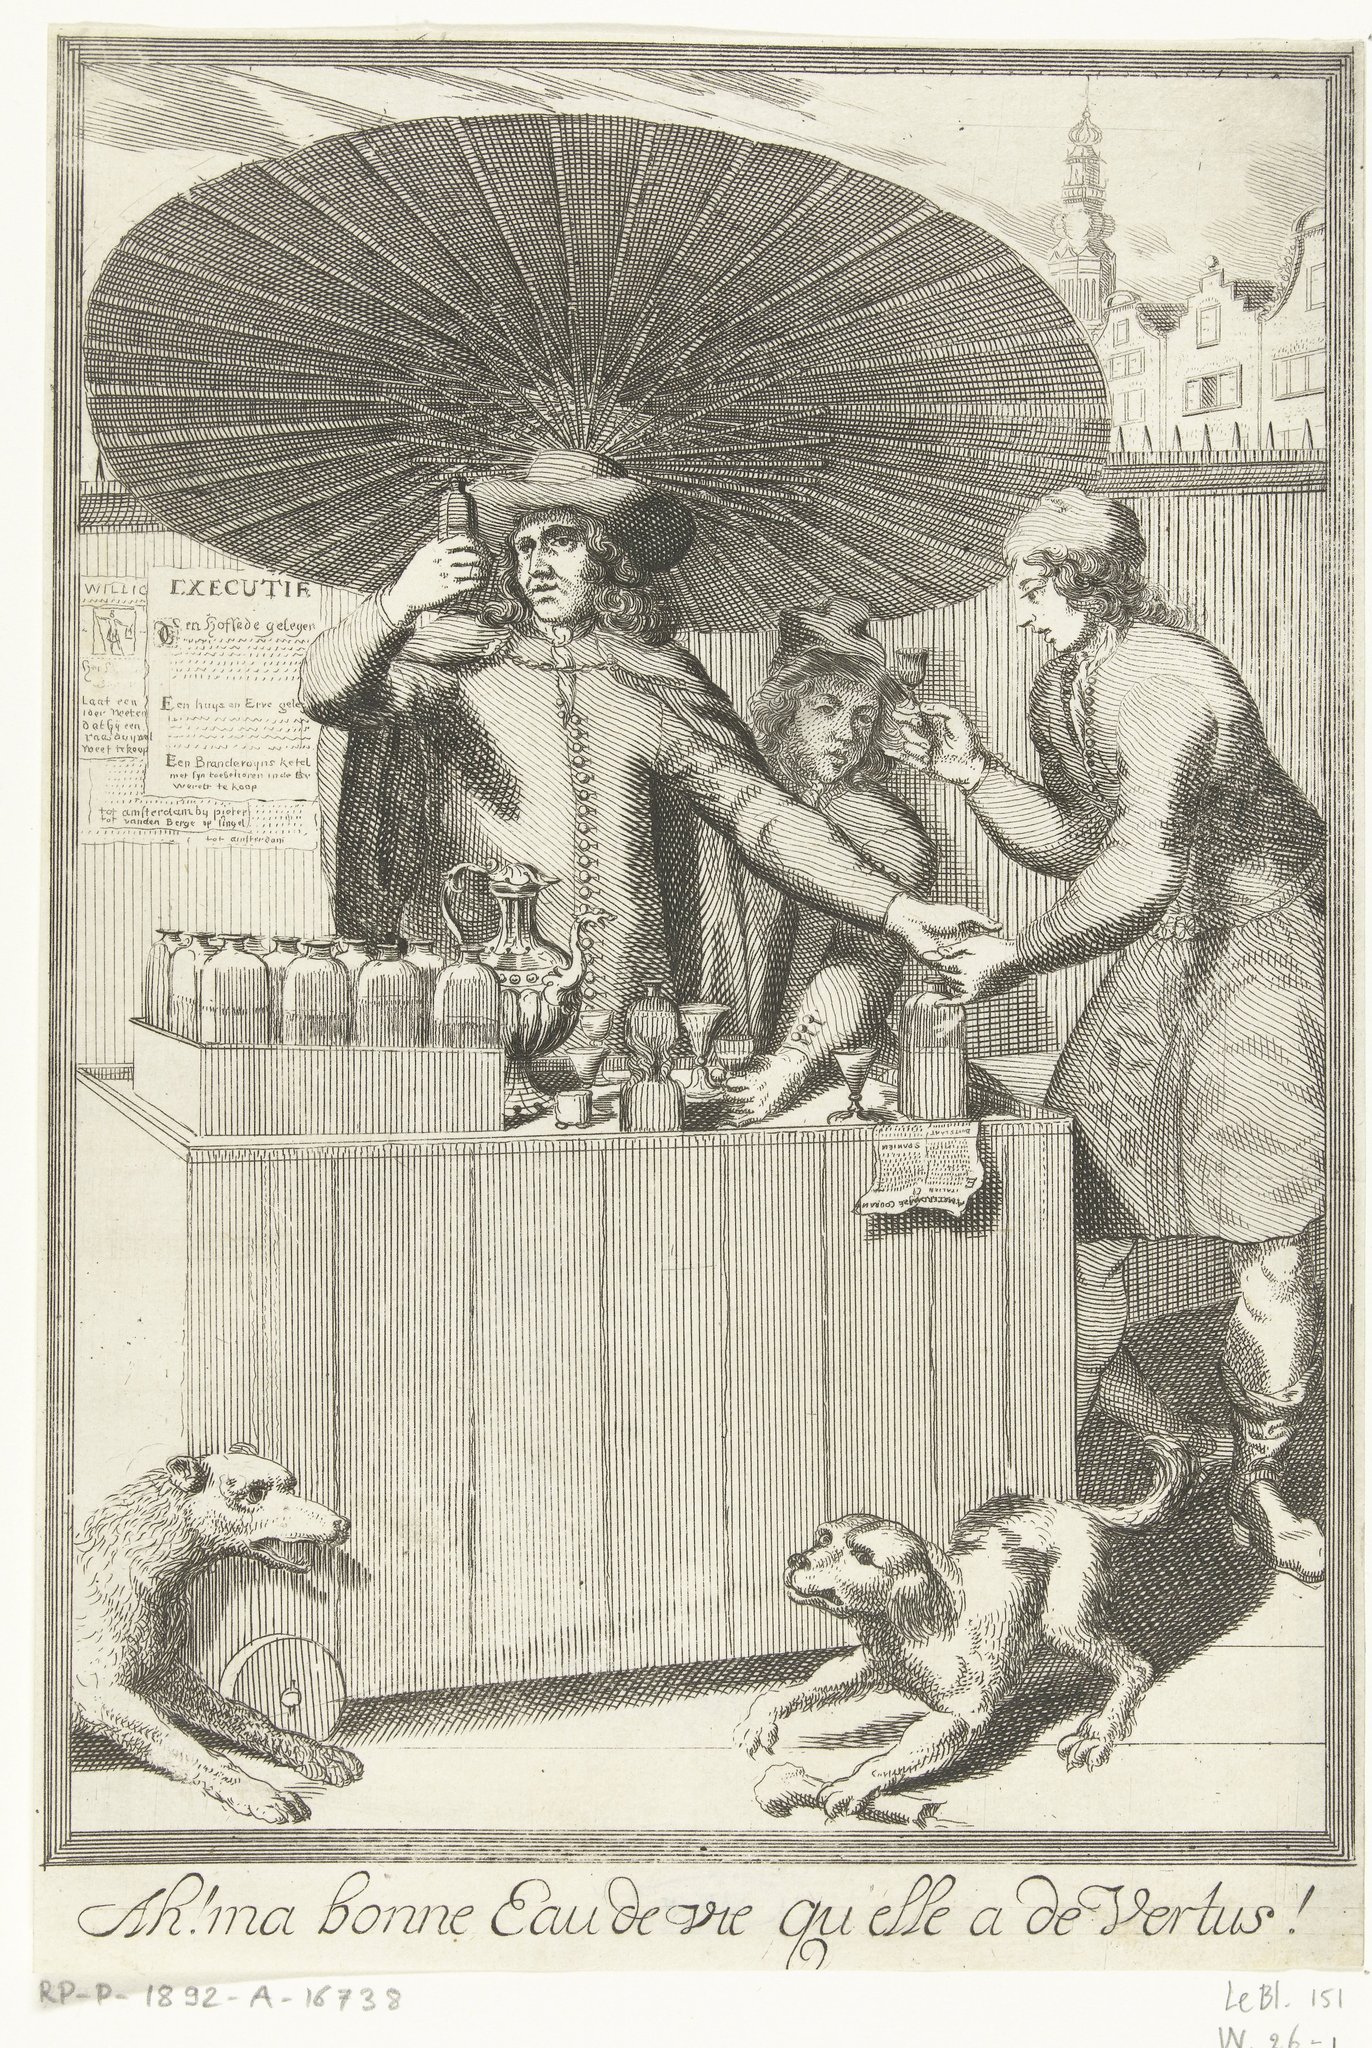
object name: print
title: Brandewijnverkoper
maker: pieter van den berge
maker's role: draughtsman, print maker, printer, publisher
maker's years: 1659-1737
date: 1694-1737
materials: paper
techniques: engraving, etching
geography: amsterdam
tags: stall, booth (~ market), wine-testing, wine-grading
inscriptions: collector's mark: Lugt 2228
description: Op de markt staat een brandewijnverkoper achter zijn kraam en biedt een klant een slokje aan. Voor de kraam vechten twee honden om een bot. Met onderschrift in het Frans: Ah! ma bonne Eau de vie qu'elle a de Vertus! Eerste prent uit een serie met zes prenten van marktkooplui.